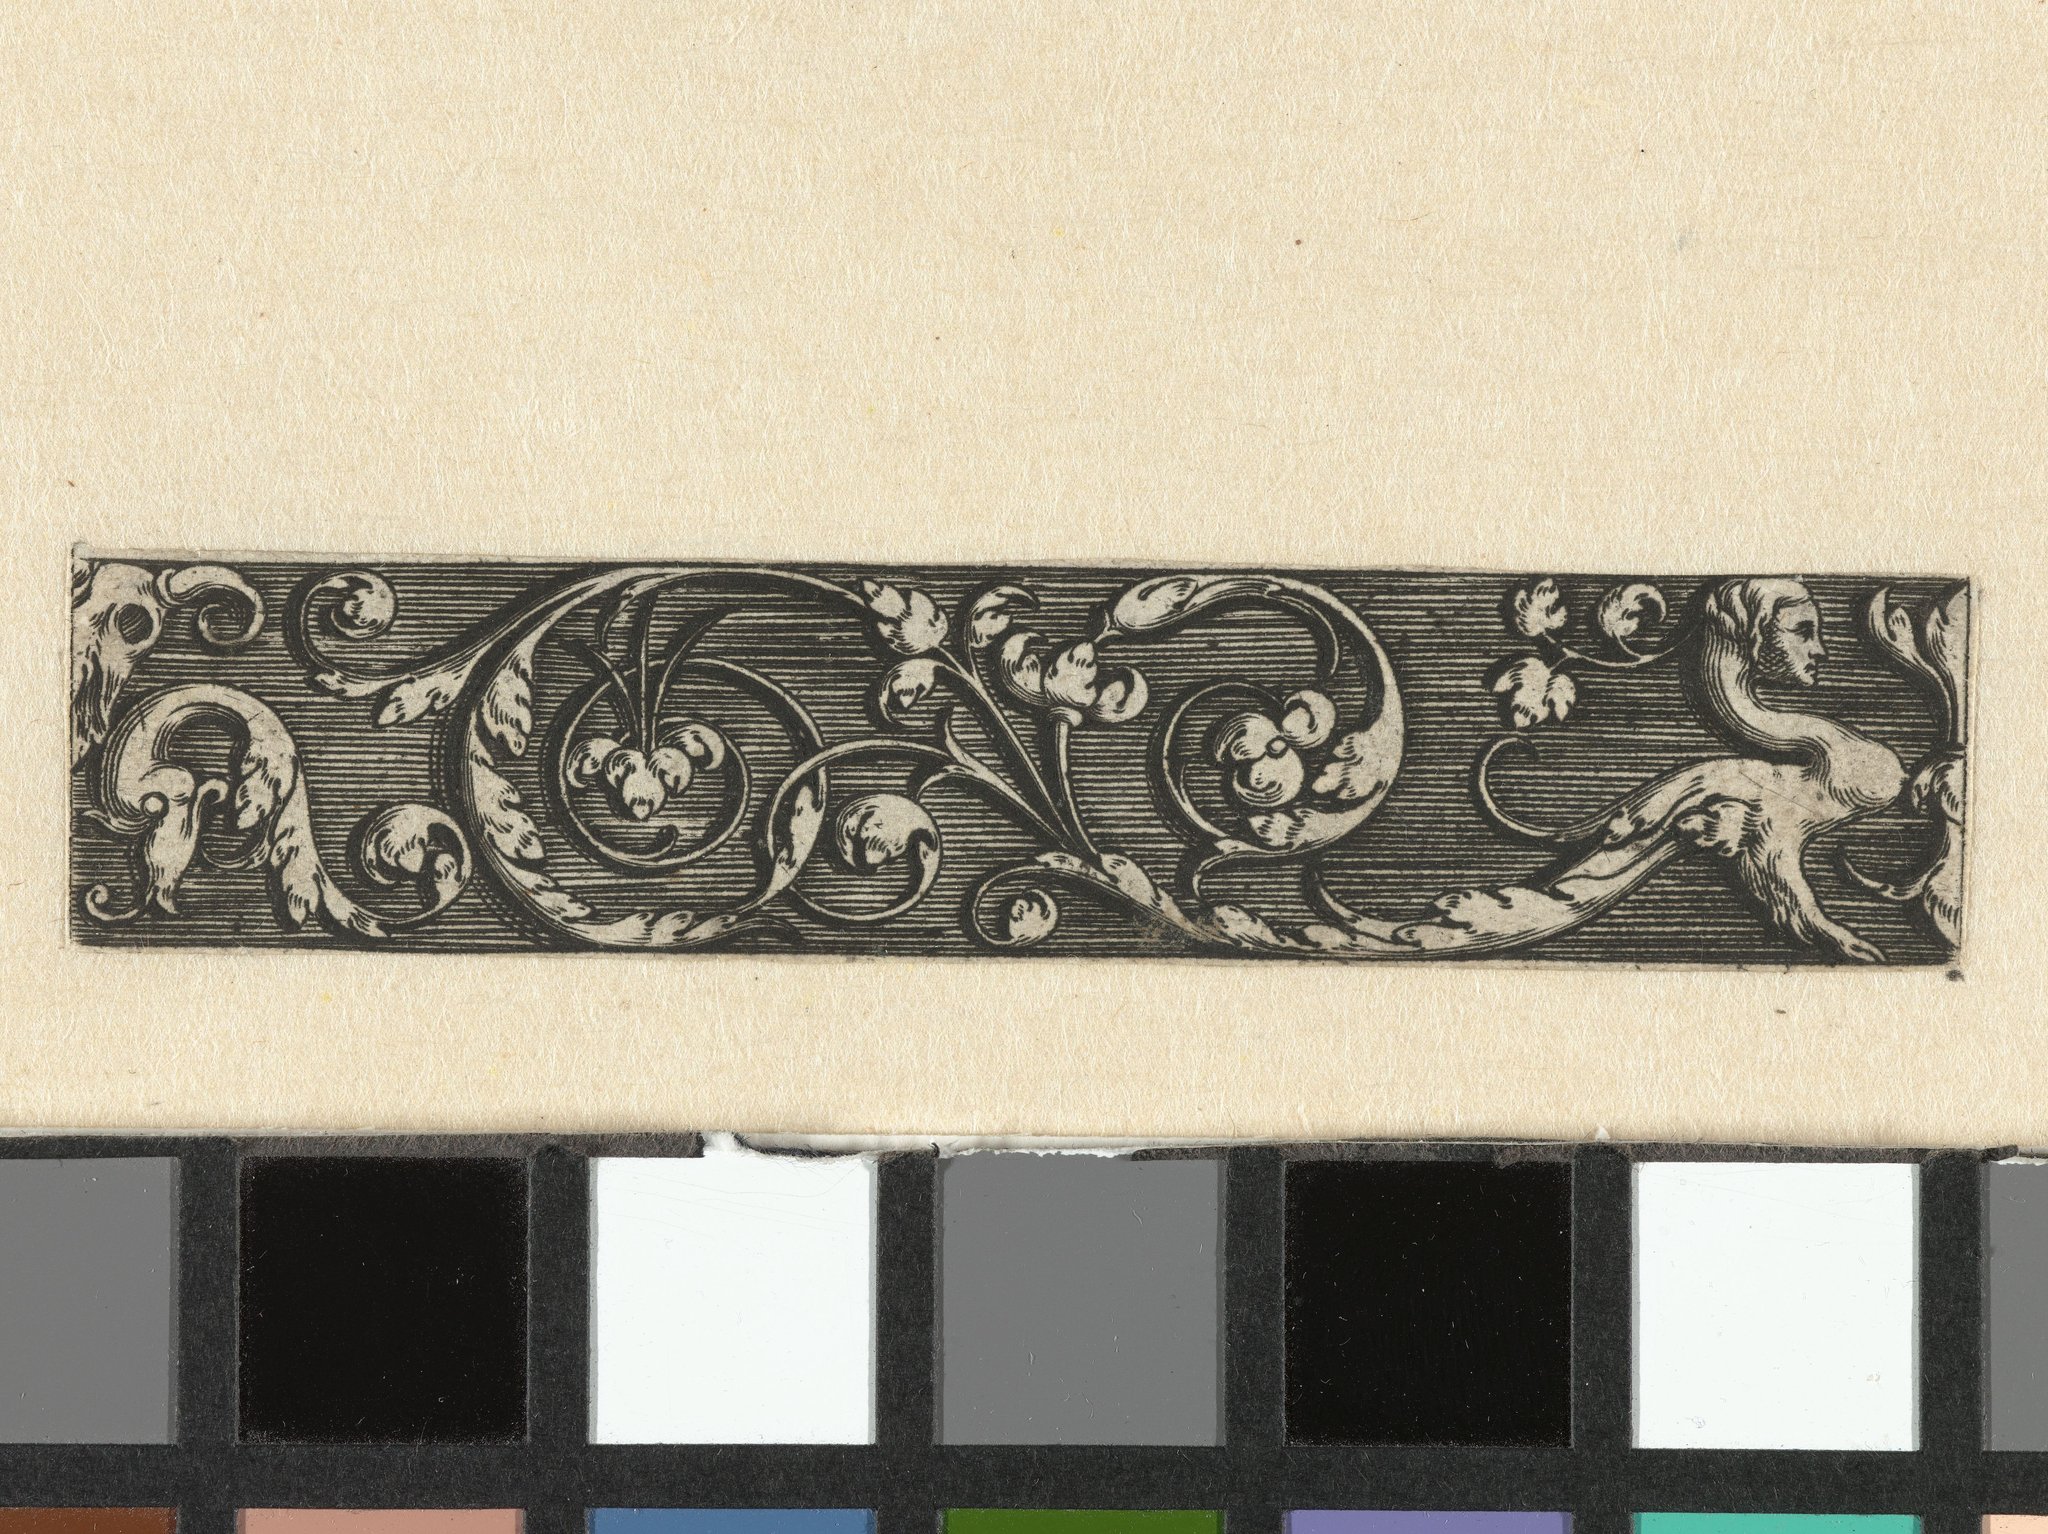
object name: print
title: Ornament met vrouwelijk fantasiewezen en ramschedel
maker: monogrammist ig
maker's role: print maker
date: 1522-1530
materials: paper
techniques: engraving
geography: low countries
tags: monsters of mixed human and animal shape; 'mostri' (ripa), animals (+ skull of an animal)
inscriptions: collector's mark: Lugt 1134, collector's mark: Lugt 2228